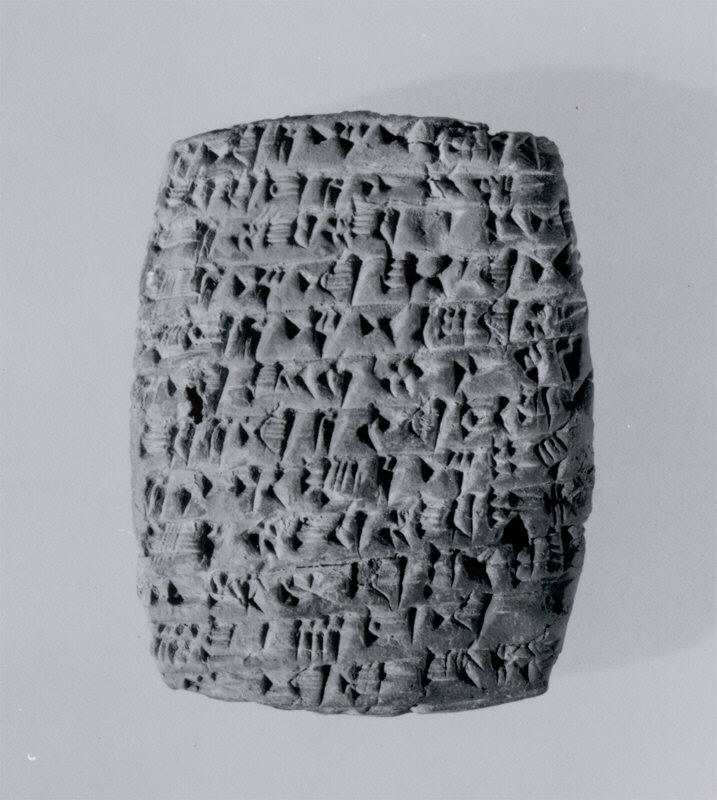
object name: cuneiform tablet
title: Cuneiform tablet: private letter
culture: assyrian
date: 2000-1801 BCE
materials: clay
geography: anatolia